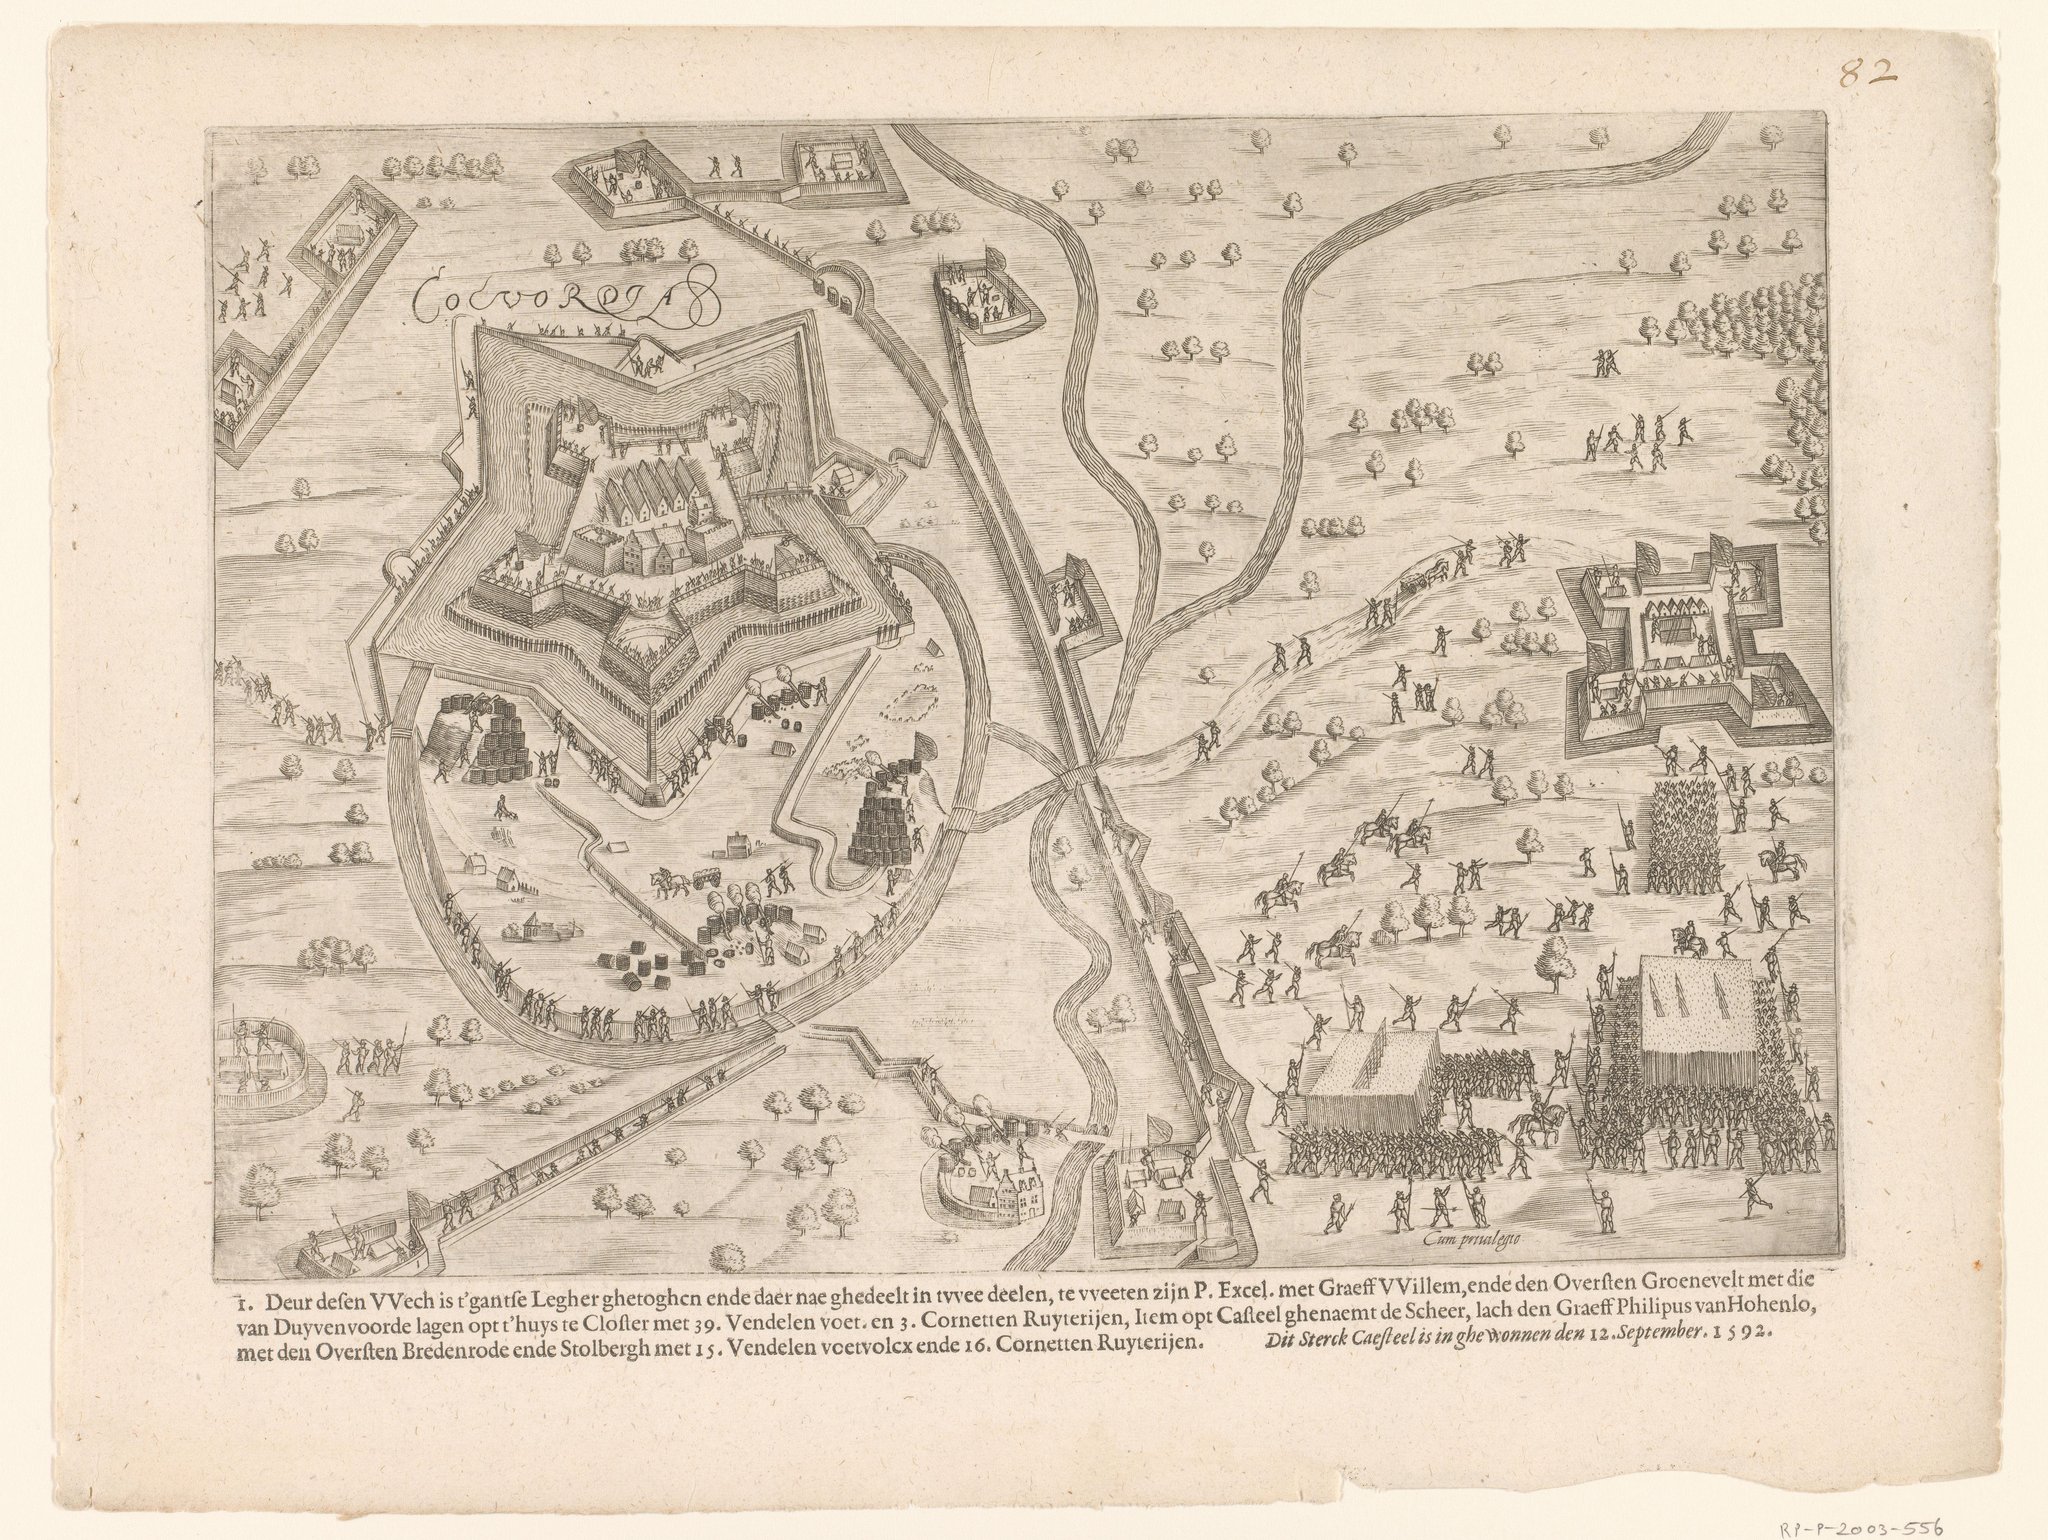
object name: history print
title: Beleg van Coevorden, 1592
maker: pieter bast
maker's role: print maker, publisher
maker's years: 1570-1605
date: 1608-1610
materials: paper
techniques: engraving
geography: northern netherlands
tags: the hague, maurice (prince of orange), capture of city (after the siege), maps of cities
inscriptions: number: ‘82’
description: Beleg van Coevorden door het Staatse leger onder Maurits en Willem Lodewijk, juli - september 1592. Plan van de vesting met het kasteel Coevorden met het omringende land met de posities van de belegerende troepen. Apart in boekdruk gedrukt onder de plaat drie regels Nederlandse tekst. met op het einde het opschrift 'Dit Sterck Casteel is in ghewonnen den 12. September. 1592.' Onderdeel van de verzameling kaarten genomen uit een latere editie van: Descrittione di tutti i Paesi Bassi van Lodovico Guicciardini.